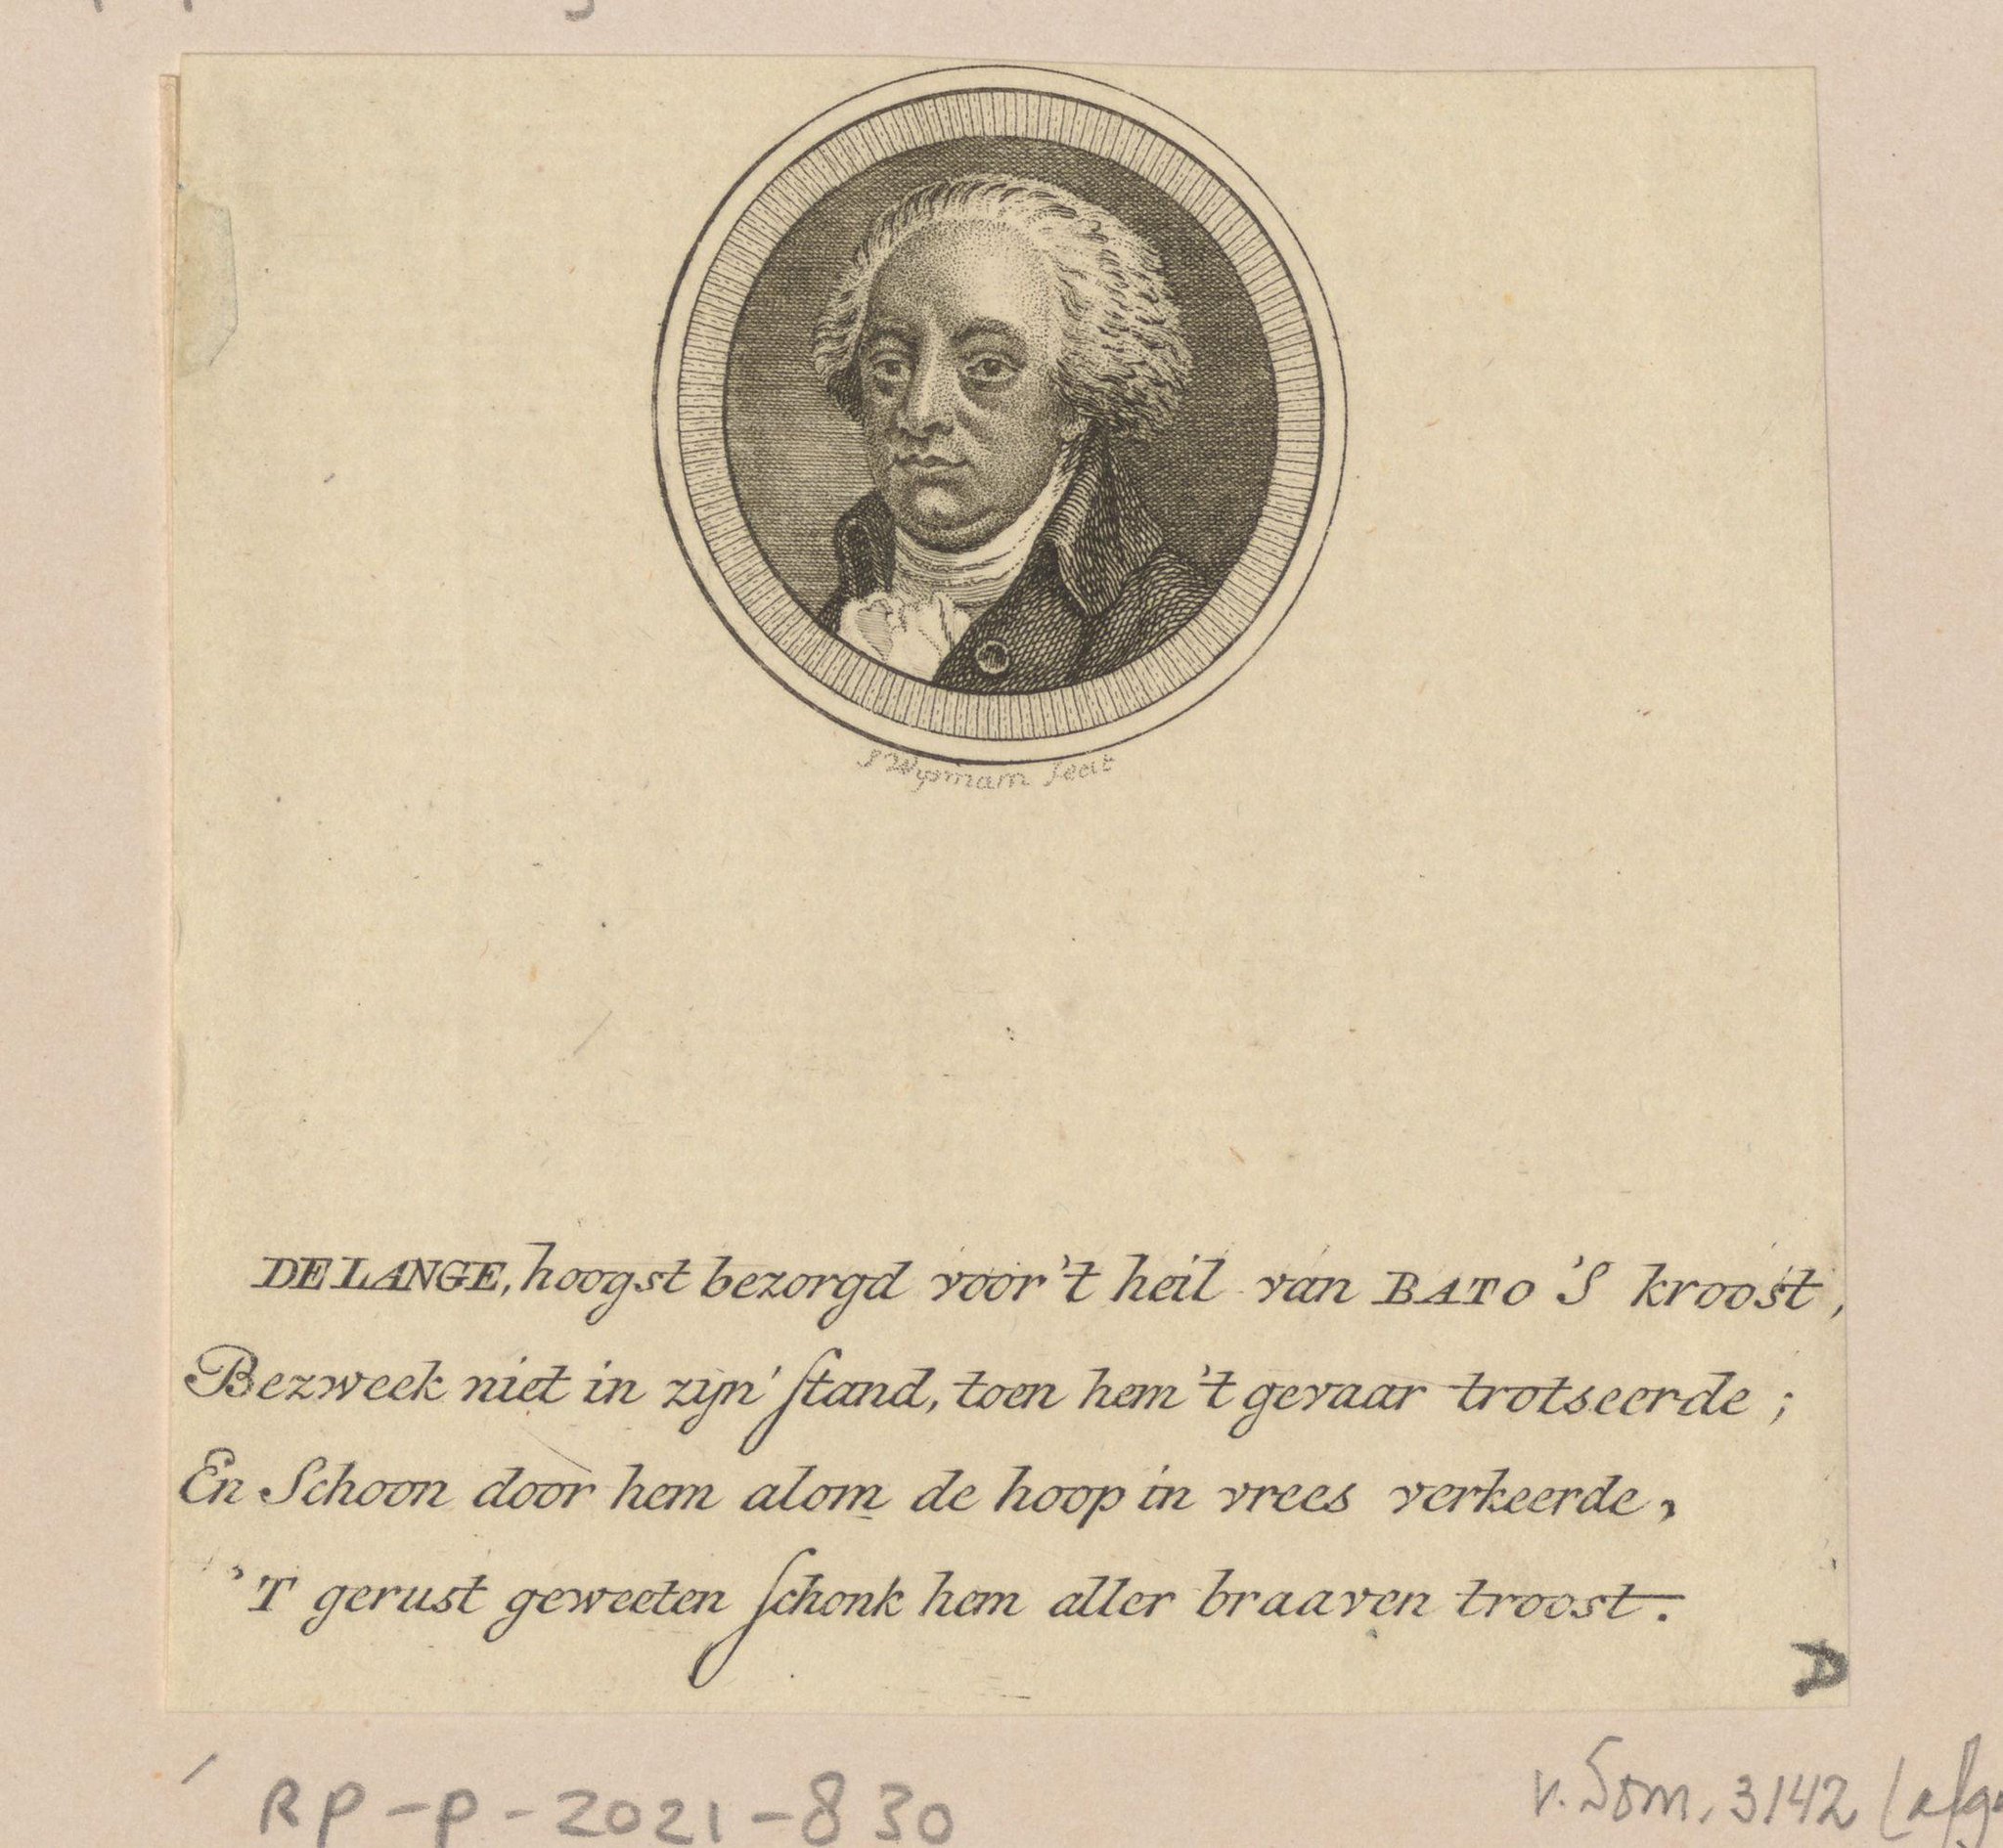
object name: print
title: Vaderlandsche Chocolaad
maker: jacobus wijsman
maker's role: print maker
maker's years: 1768-1827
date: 1796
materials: paper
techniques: etching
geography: amsterdam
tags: gouda, historical persons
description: Prent waarschijnlijk uit: Nomsz, Johannes. Vaderlandsche chocolaad. Amsterdam: Dirk Meland Langeveld, 1796. Jacobus Wijsman heeft sommige platen van de serie patriottenportretten van Abraham Jacobsz. Hulk aangepast en hergebruikt in zijn eigen serie patriottenportretten. Prent is mogelijk in een eerdere staat gebruikt in een serie patriottenportretten die in drie afleveringen werd uitgegeven onder de titel: Verzameling van Afbeeldingen van Nederlandsche Mannen, beroemd geworden, wegens hunne Moed en Burgerliefde in de jongstledene Beroerten, 1794-1795. Zie Atlas van Stolk en Van Someren.